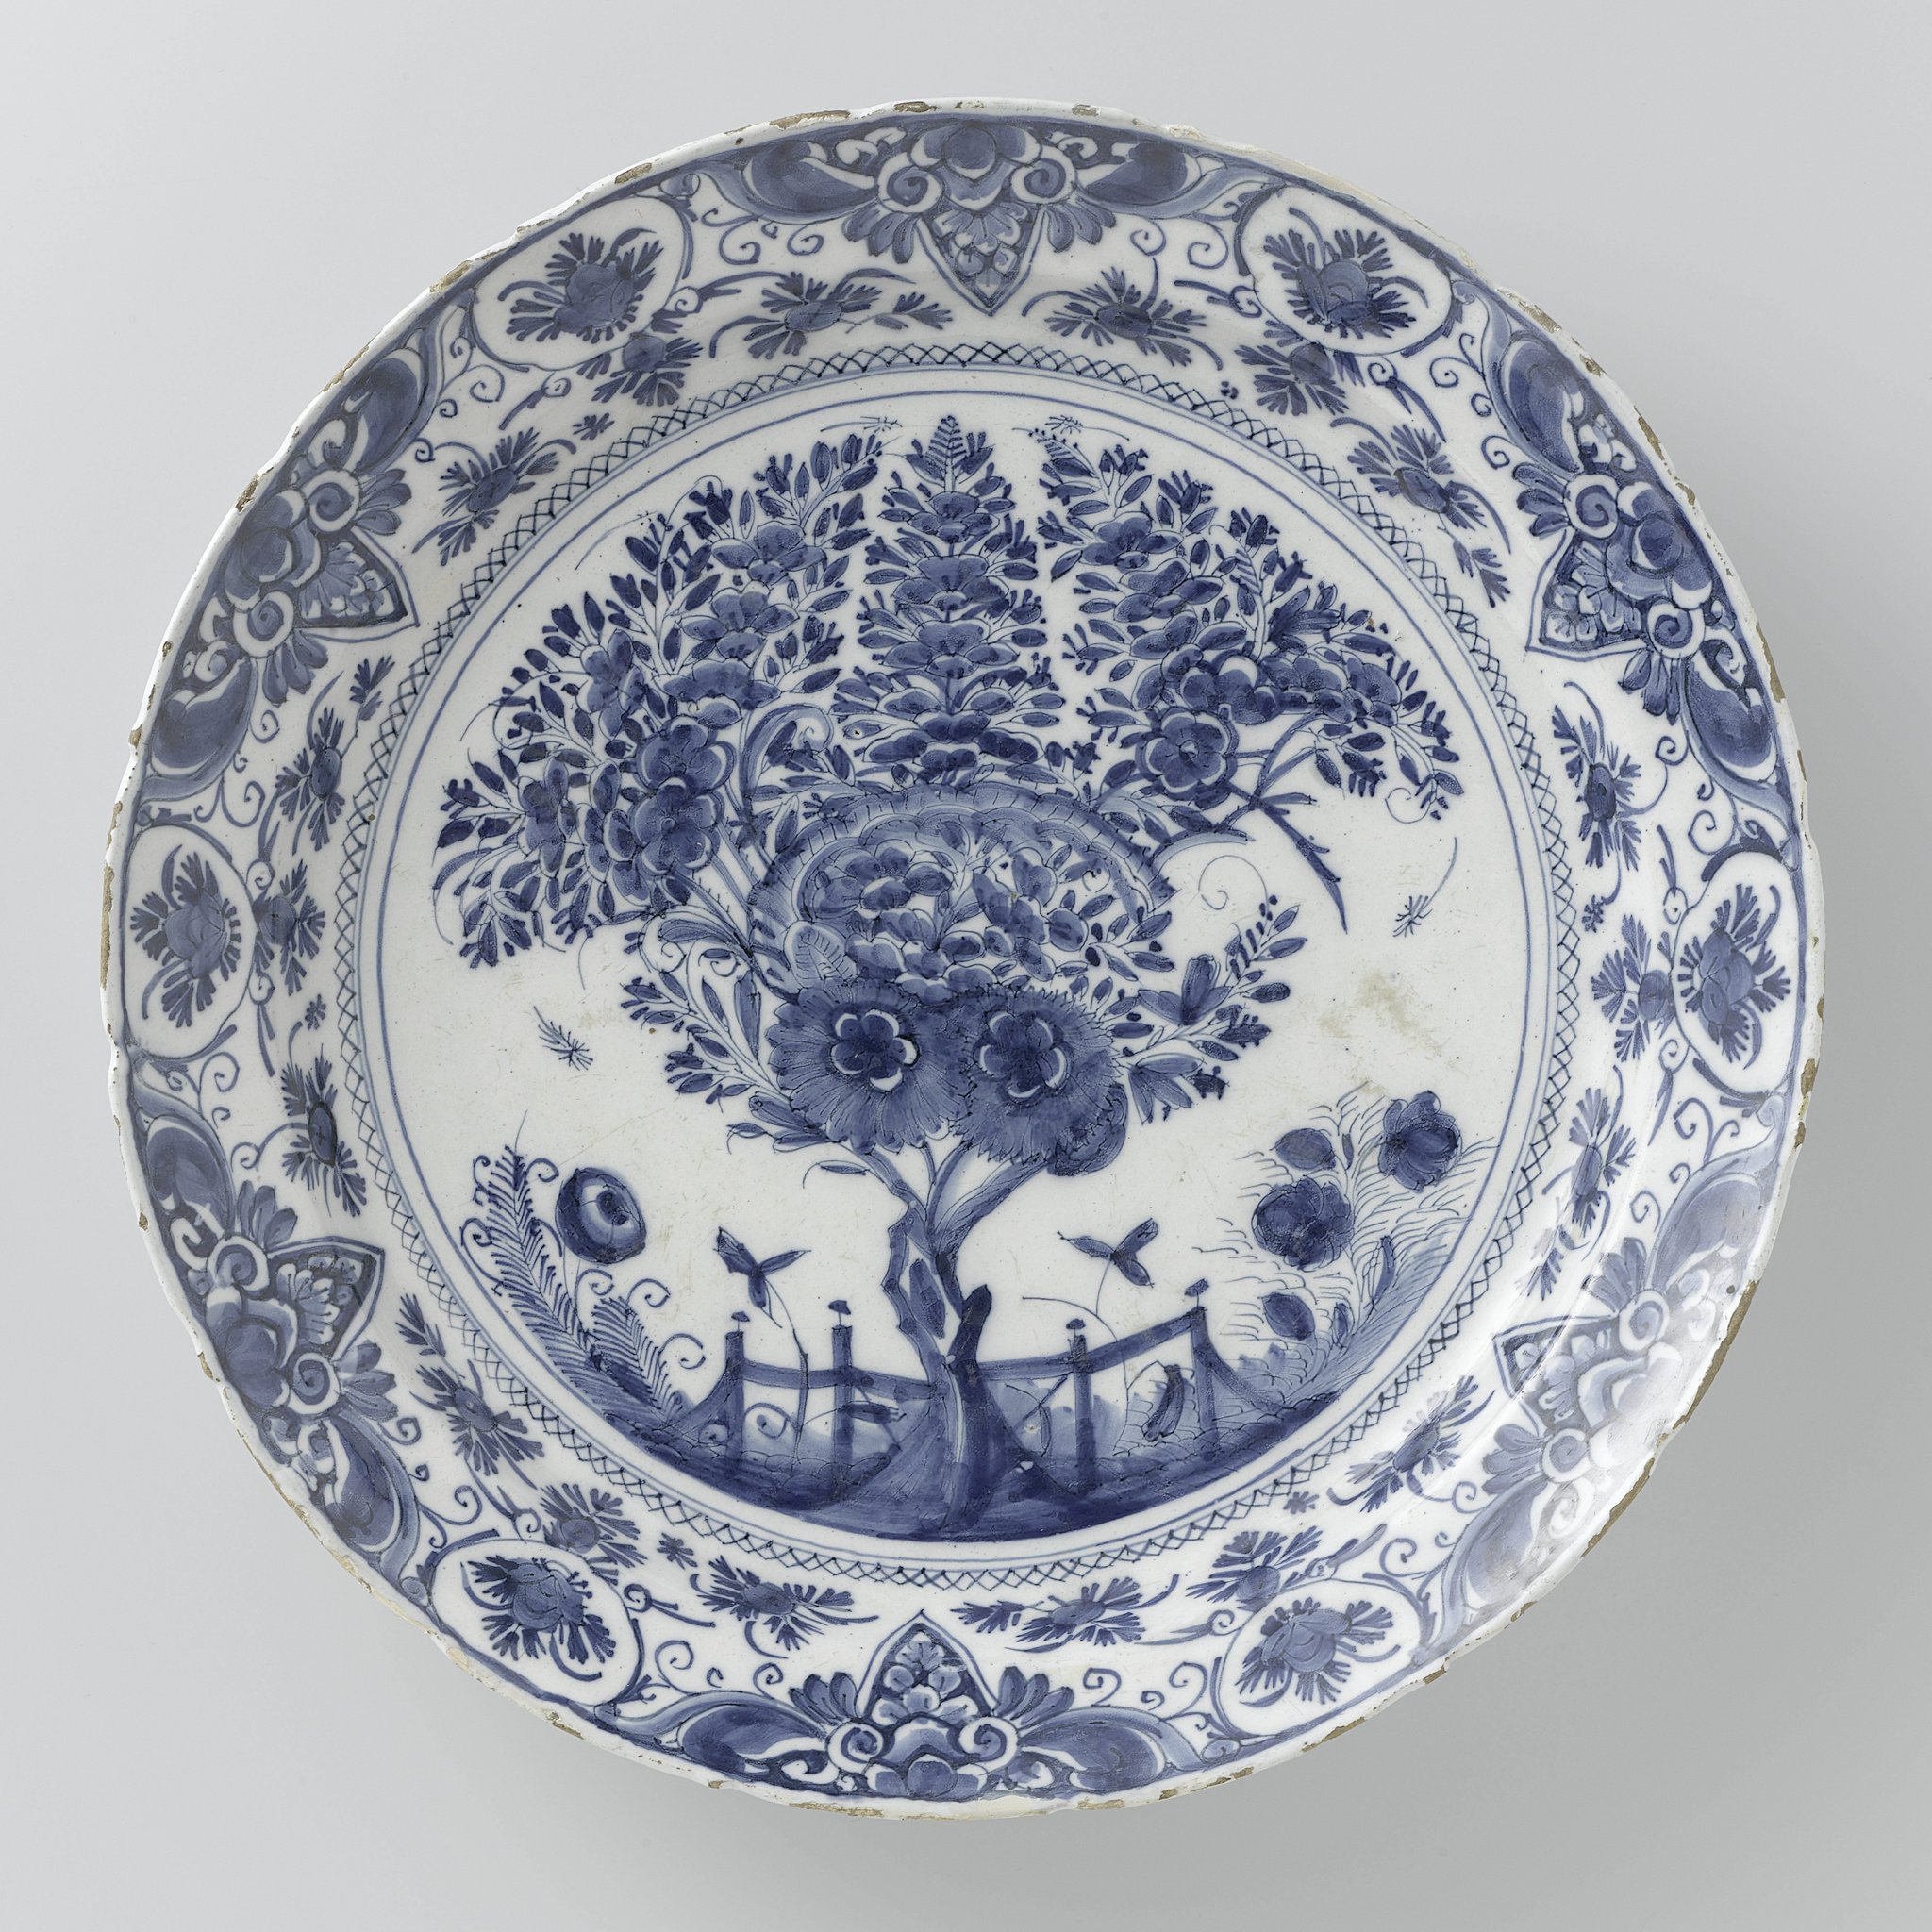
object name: platter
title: Schotel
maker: cornelis brouwer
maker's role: print maker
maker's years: 1731-1803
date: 1725-1750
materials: earthenware, glaze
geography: delft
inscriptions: mark: ‘CB./ figuratief teken ster’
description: Schotel van faience. Blauw beschilderd met een fantasie-boom.